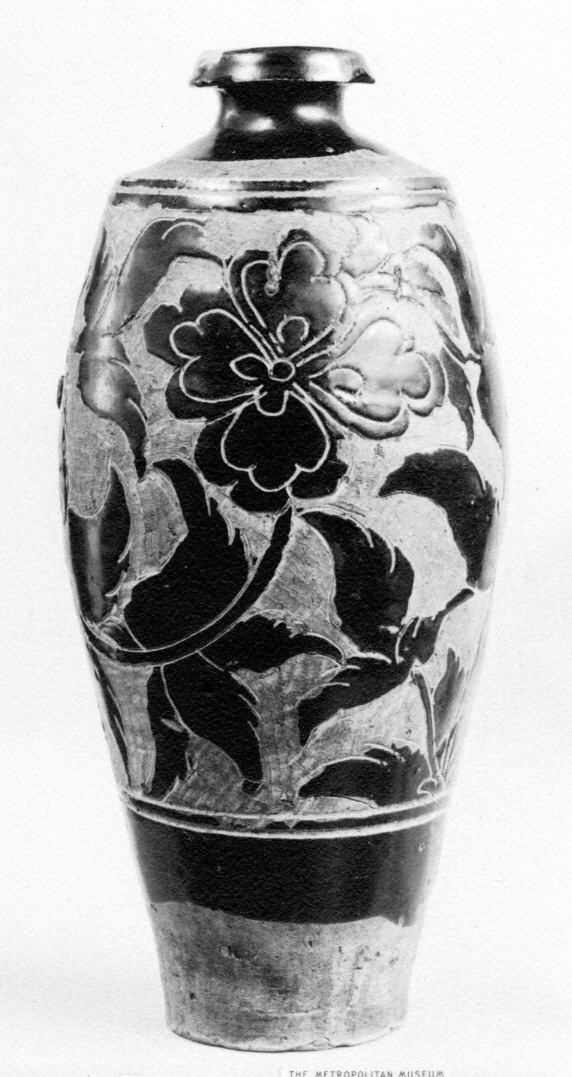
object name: bottle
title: Bottle with Floral Decoration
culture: chinese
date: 1101-1300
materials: stoneware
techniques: cutting, glazing, incising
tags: flowers,leaves